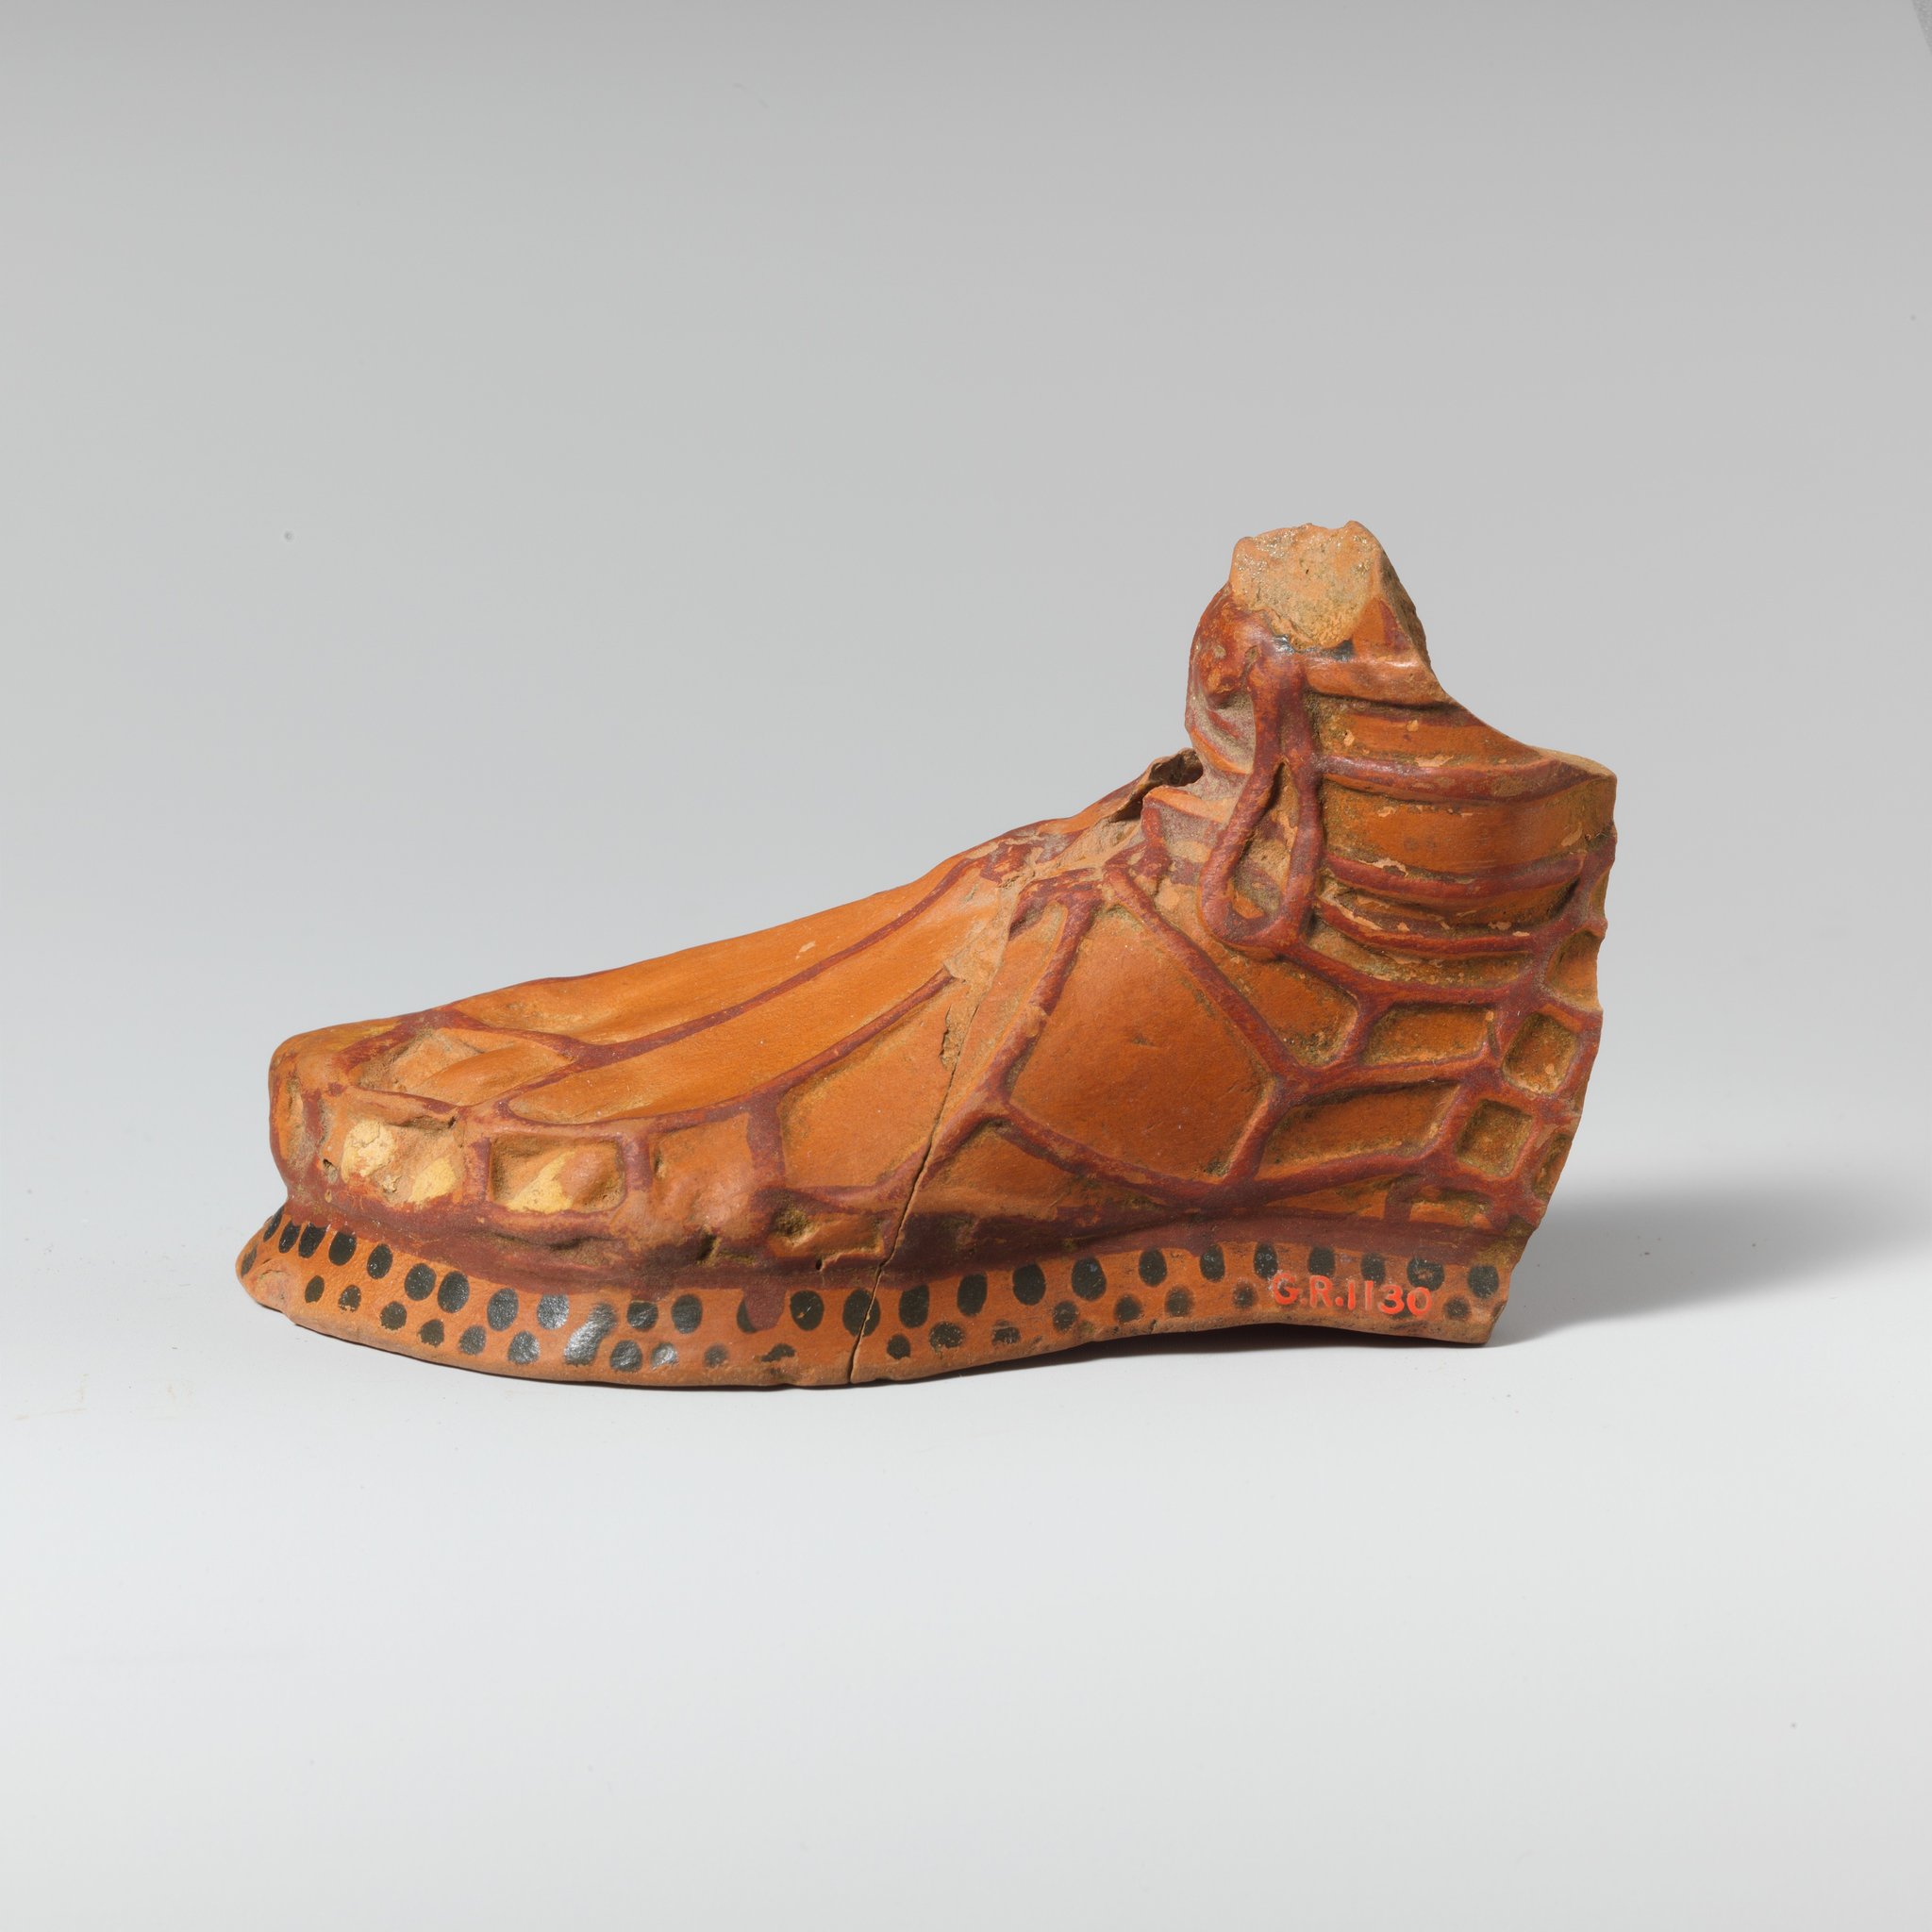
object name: aryballos in the form of a foot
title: Terracotta aryballos in the form of a sandaled foot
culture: east greek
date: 600-501 BCE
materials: terracotta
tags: feet